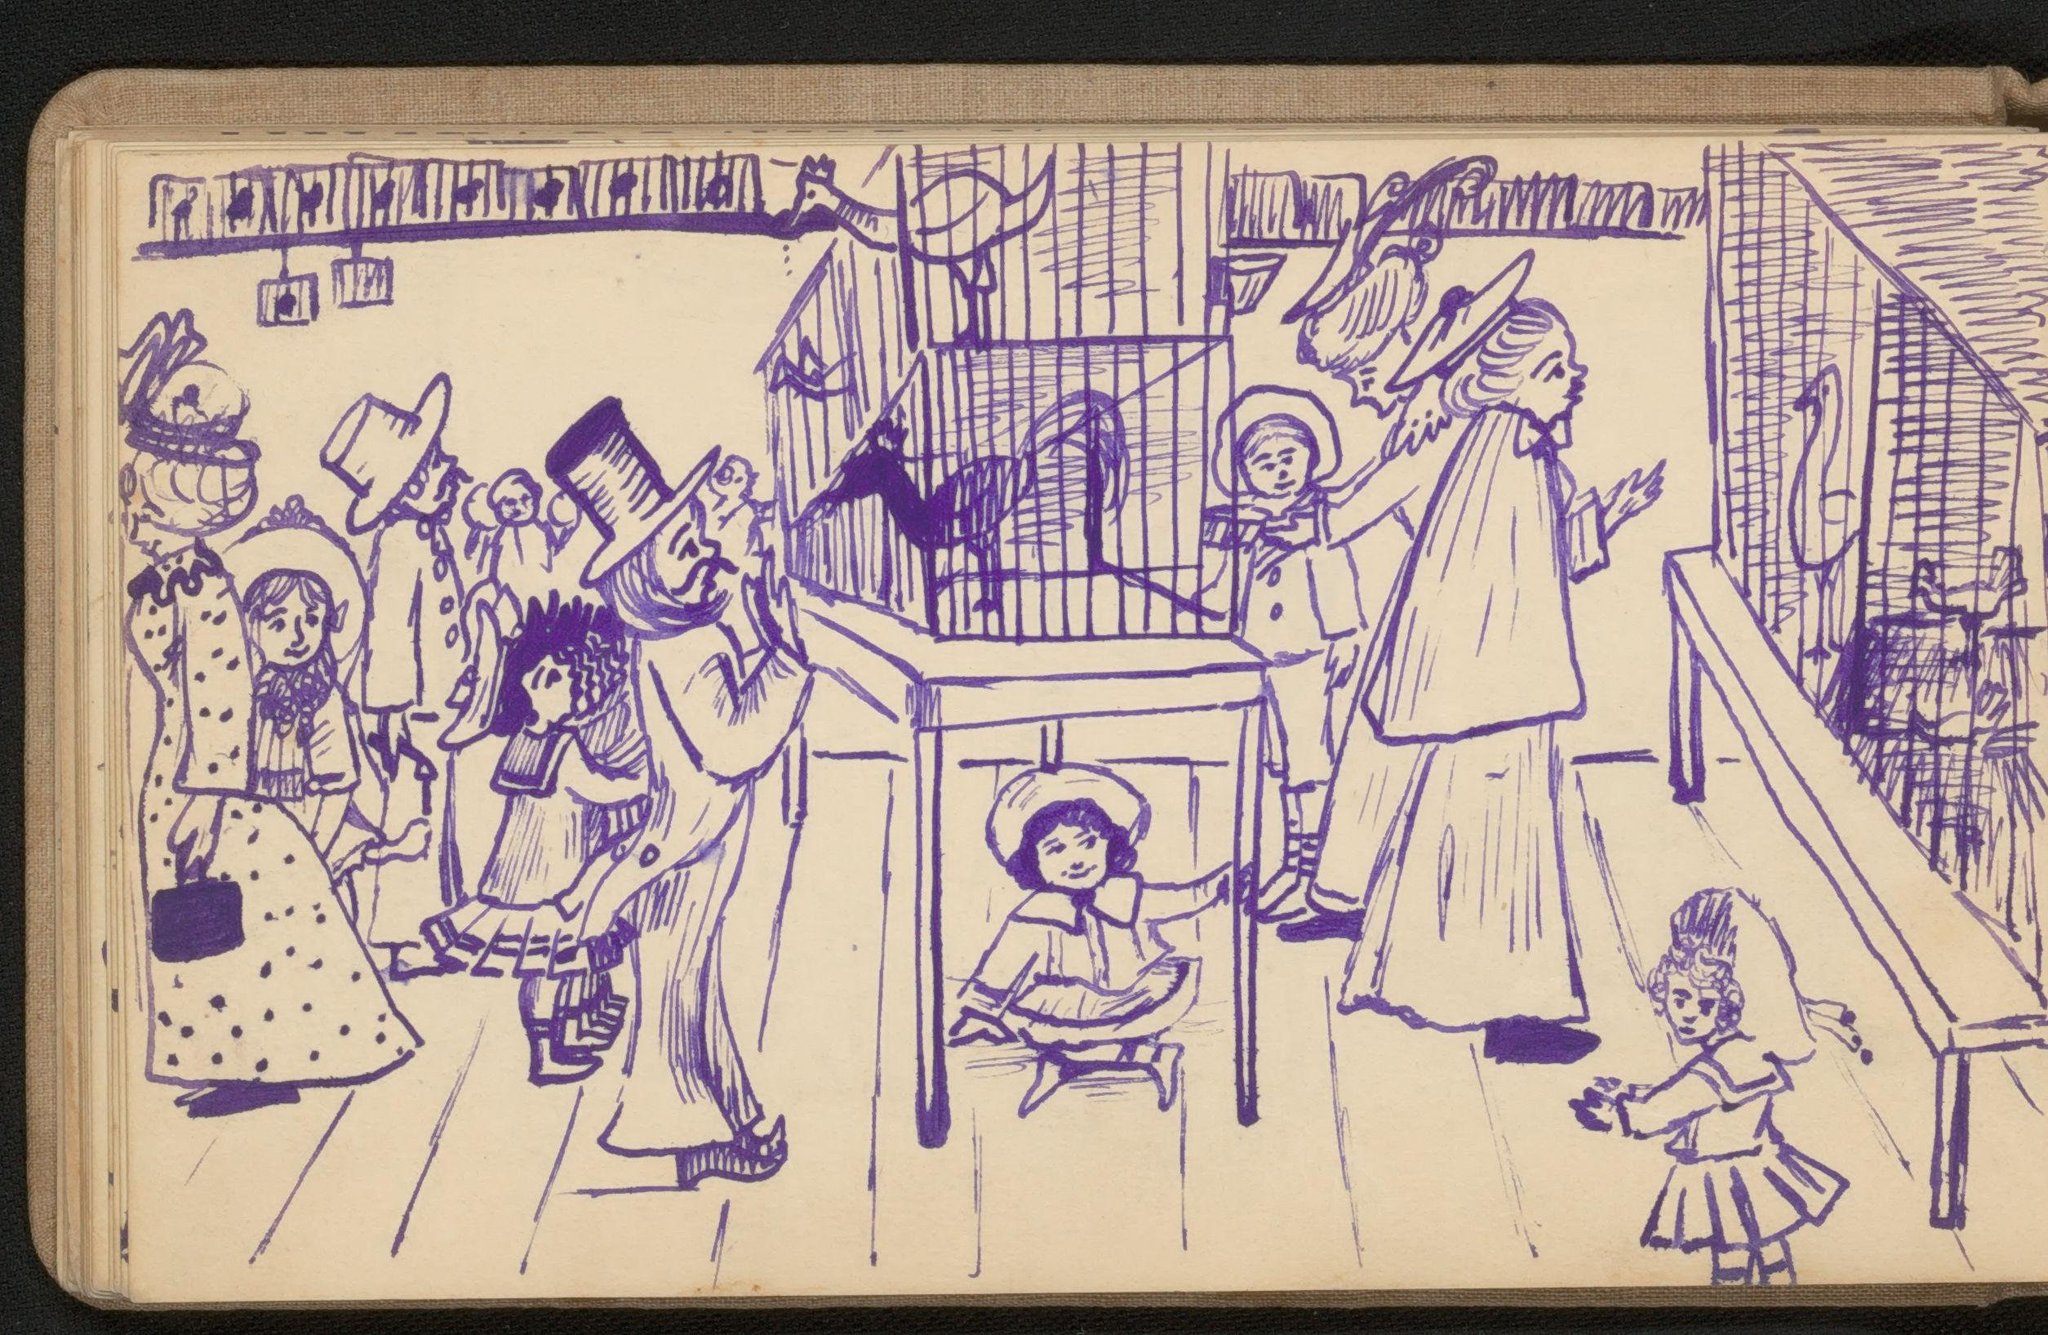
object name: sketchbook leaf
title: In de tentoonstelling van pluimvee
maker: Anonymous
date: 1875-1920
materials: ink, paper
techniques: pen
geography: netherlands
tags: fowl (cock, hen, chicken, etc.), collection, exhibition, show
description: De familie brengt een bezoek aan de 'Tentoonstelling van Pluimgedierte'. Onderdeel van het schetsboek met humoristische tekeningen over het leven van een 'famille nombreuse'. Onderwerpsrubrieken binnen de Atlas Zeden en Gewoonten: Zeden en Gewoonten in Engeren Zin, Des menschen beging, midden en einde, Kinderleven.